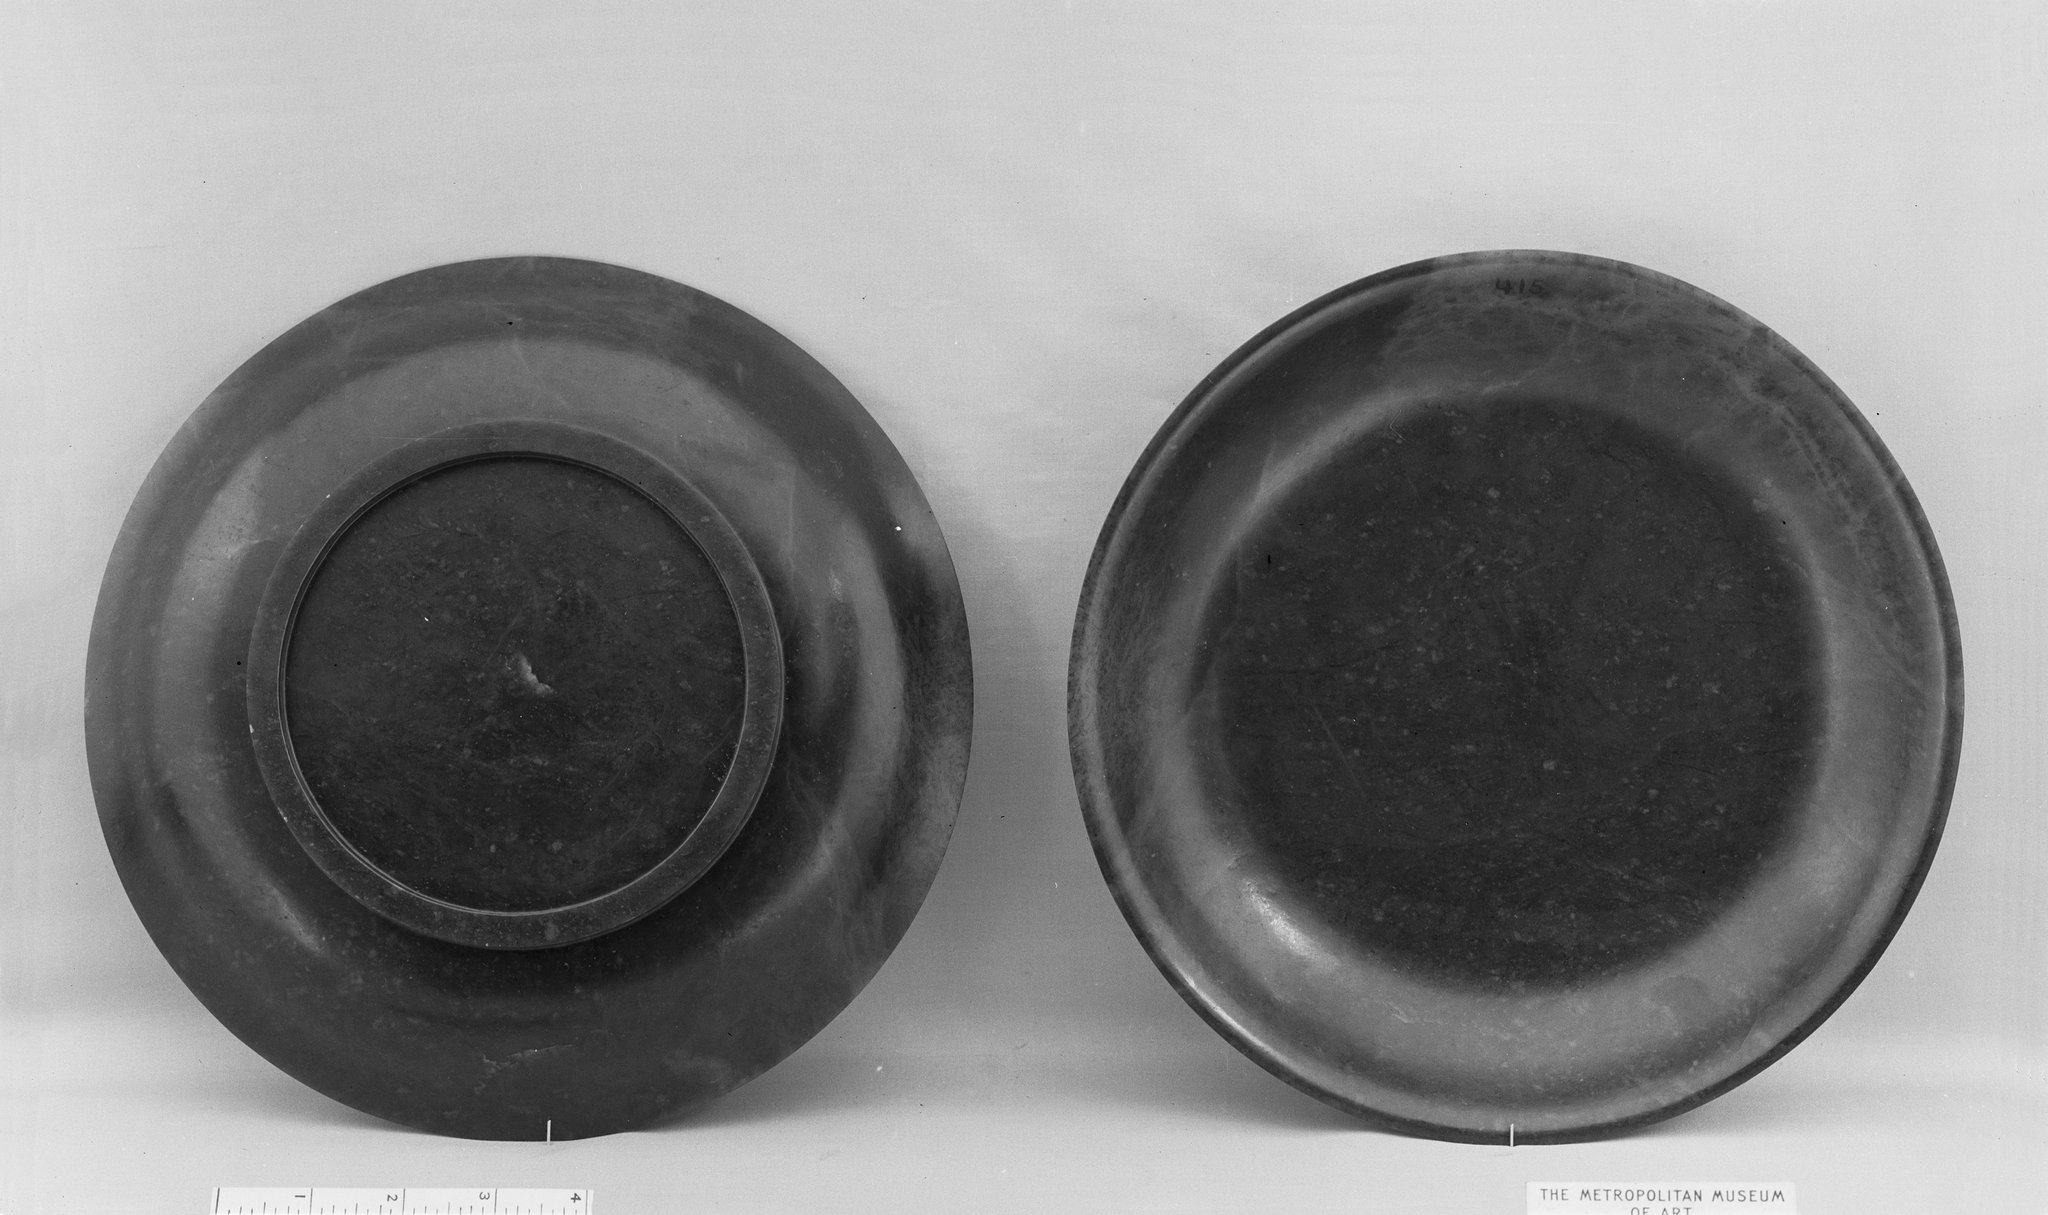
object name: dish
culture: chinese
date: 1368-1644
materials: jade